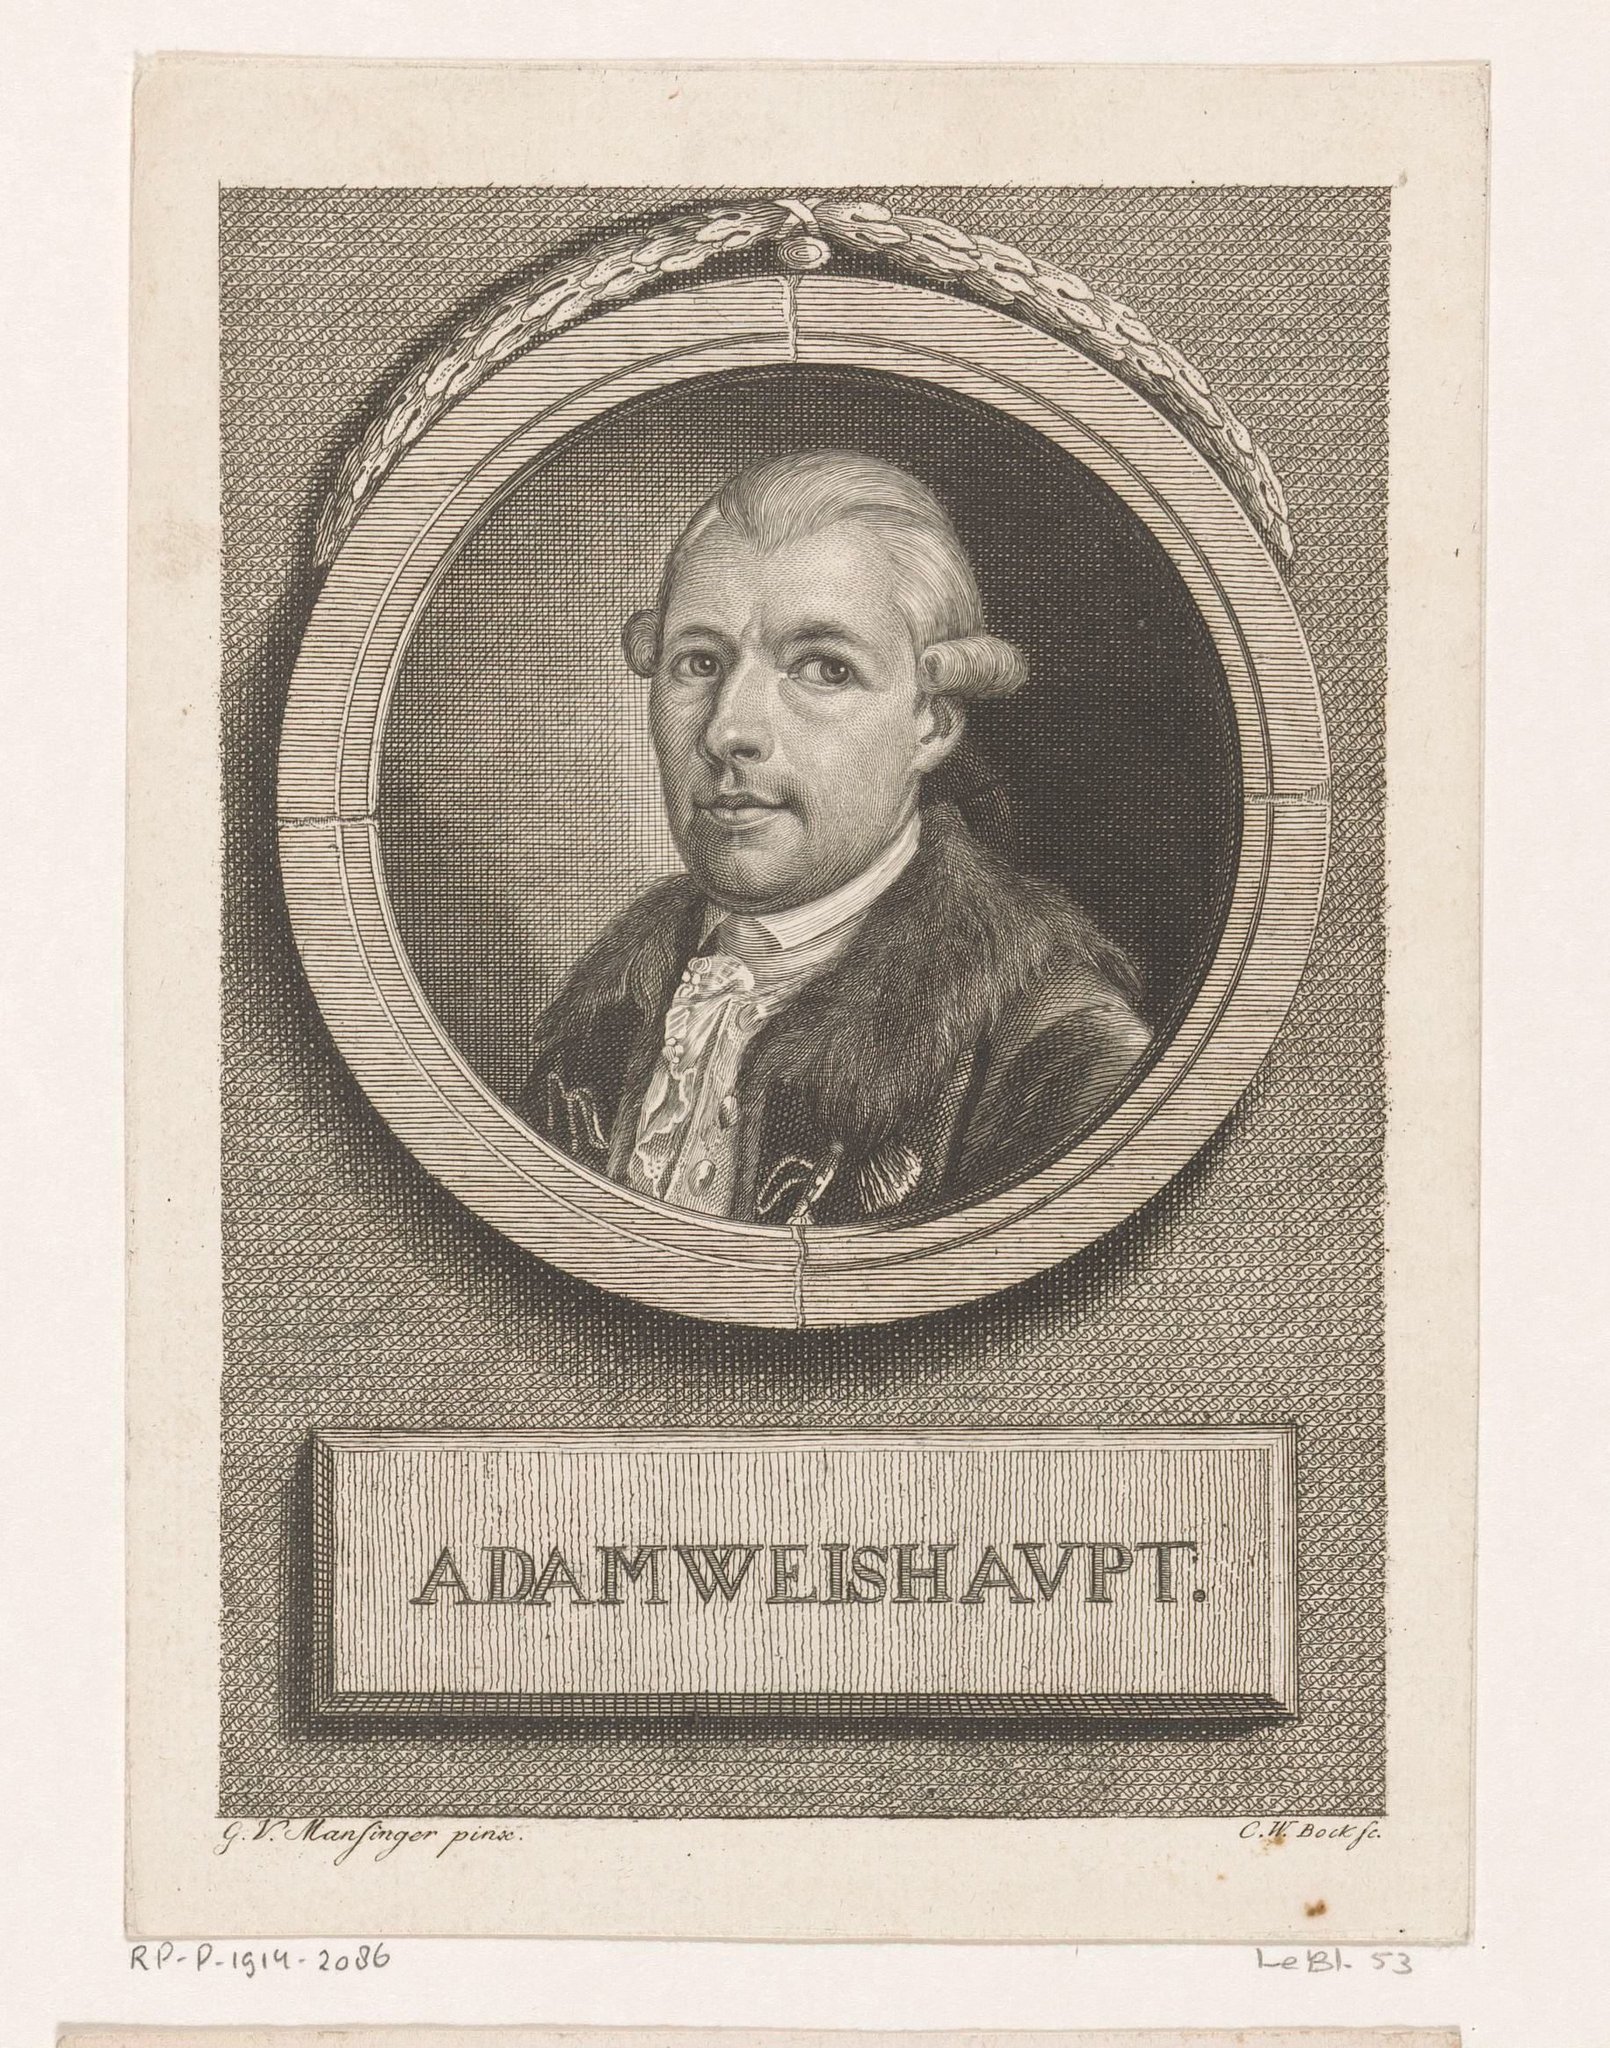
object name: print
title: Portret van Adam Weishaupt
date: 1765-1836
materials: paper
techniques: engraving, etching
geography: nuremberg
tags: historical persons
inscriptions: collector's mark: Lugt 2228